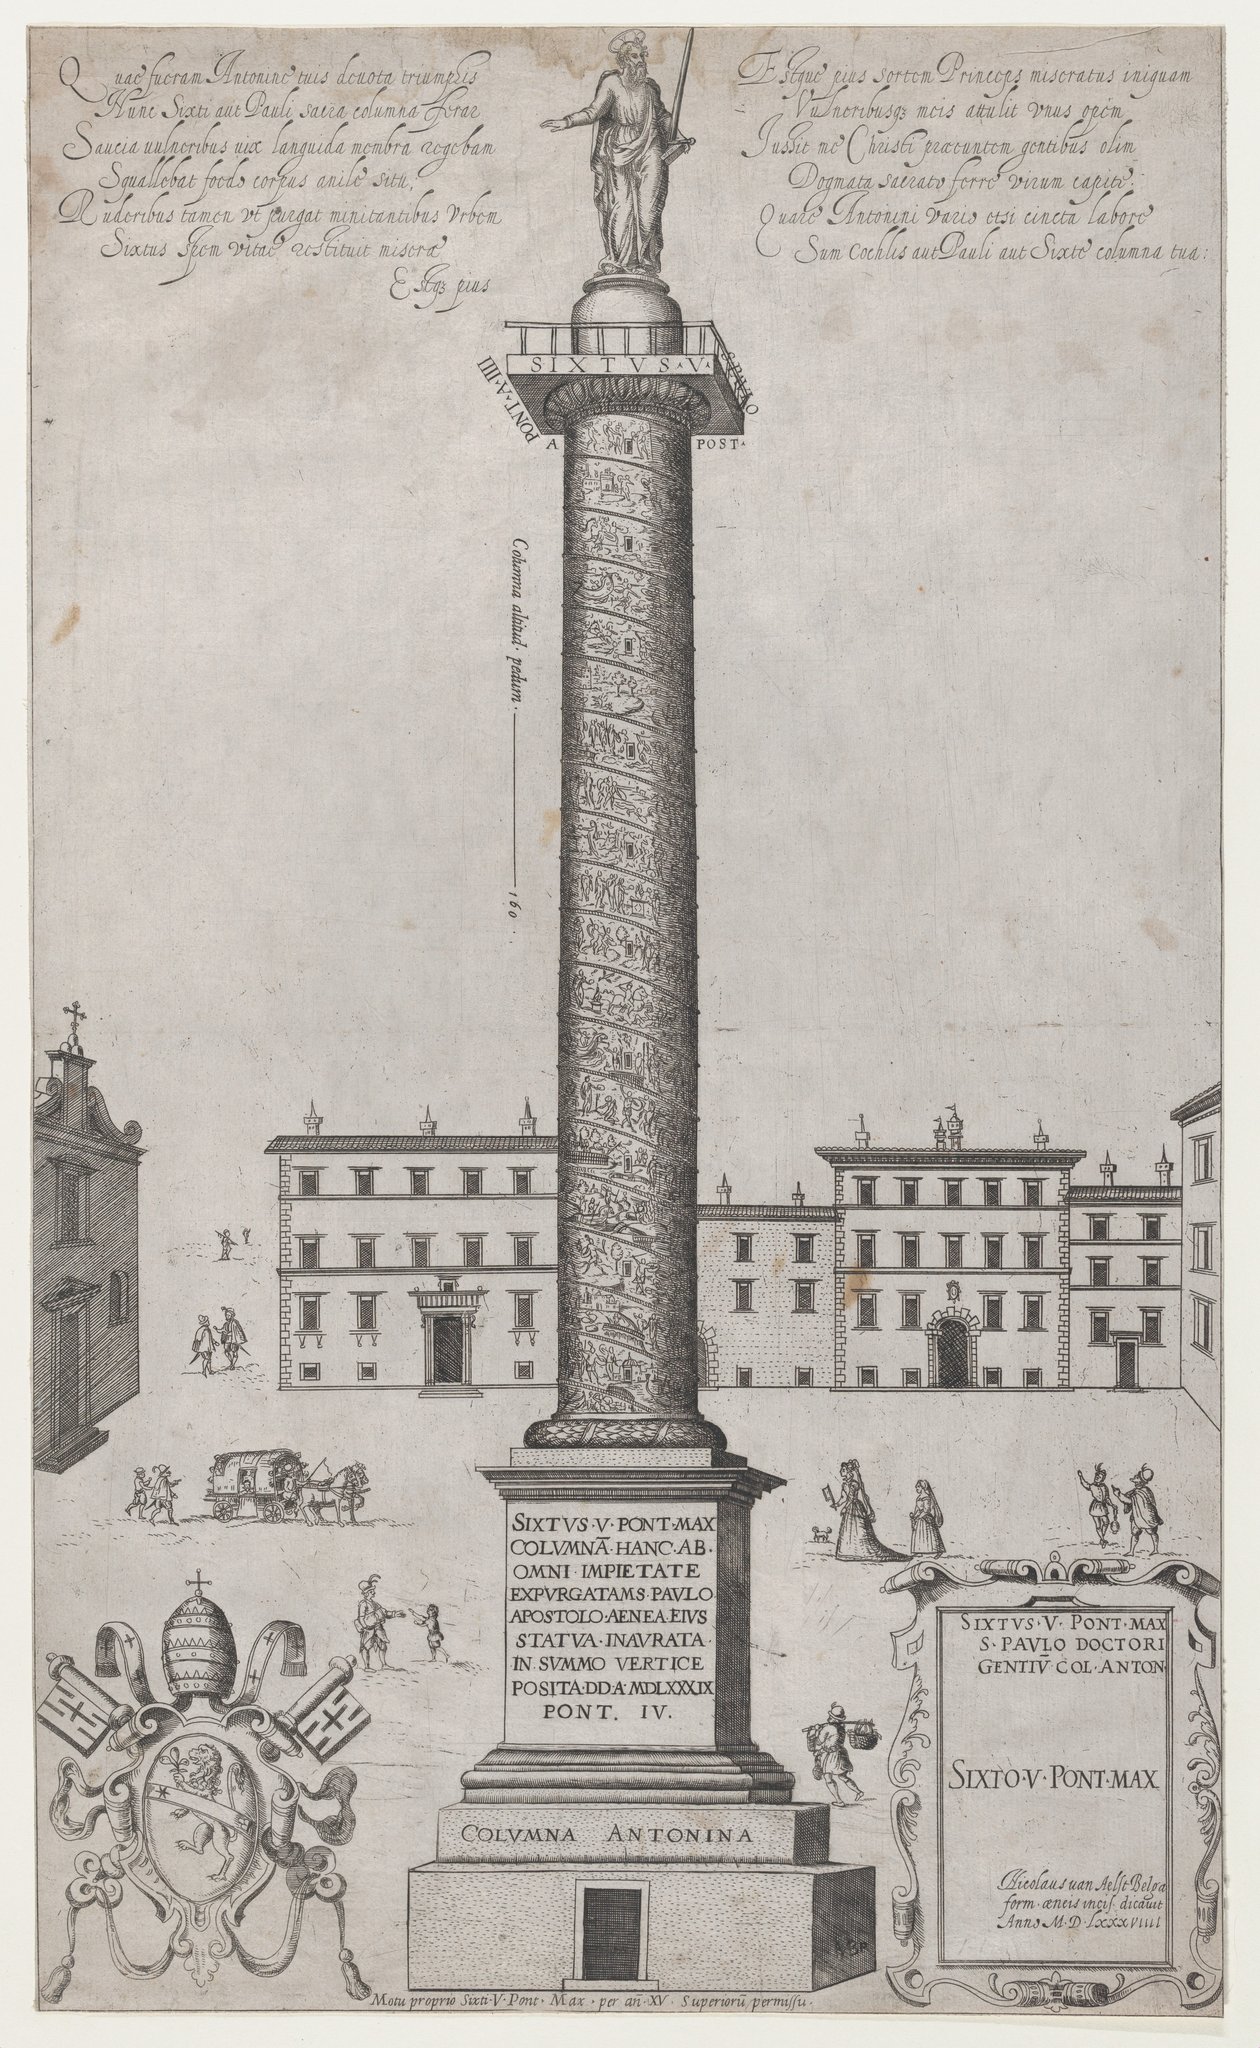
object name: print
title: The Antonine Column, from "Speculum Romanae Magnificentiae"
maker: Anonymous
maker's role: artist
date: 1589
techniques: engraving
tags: monuments,coat of arms,rome